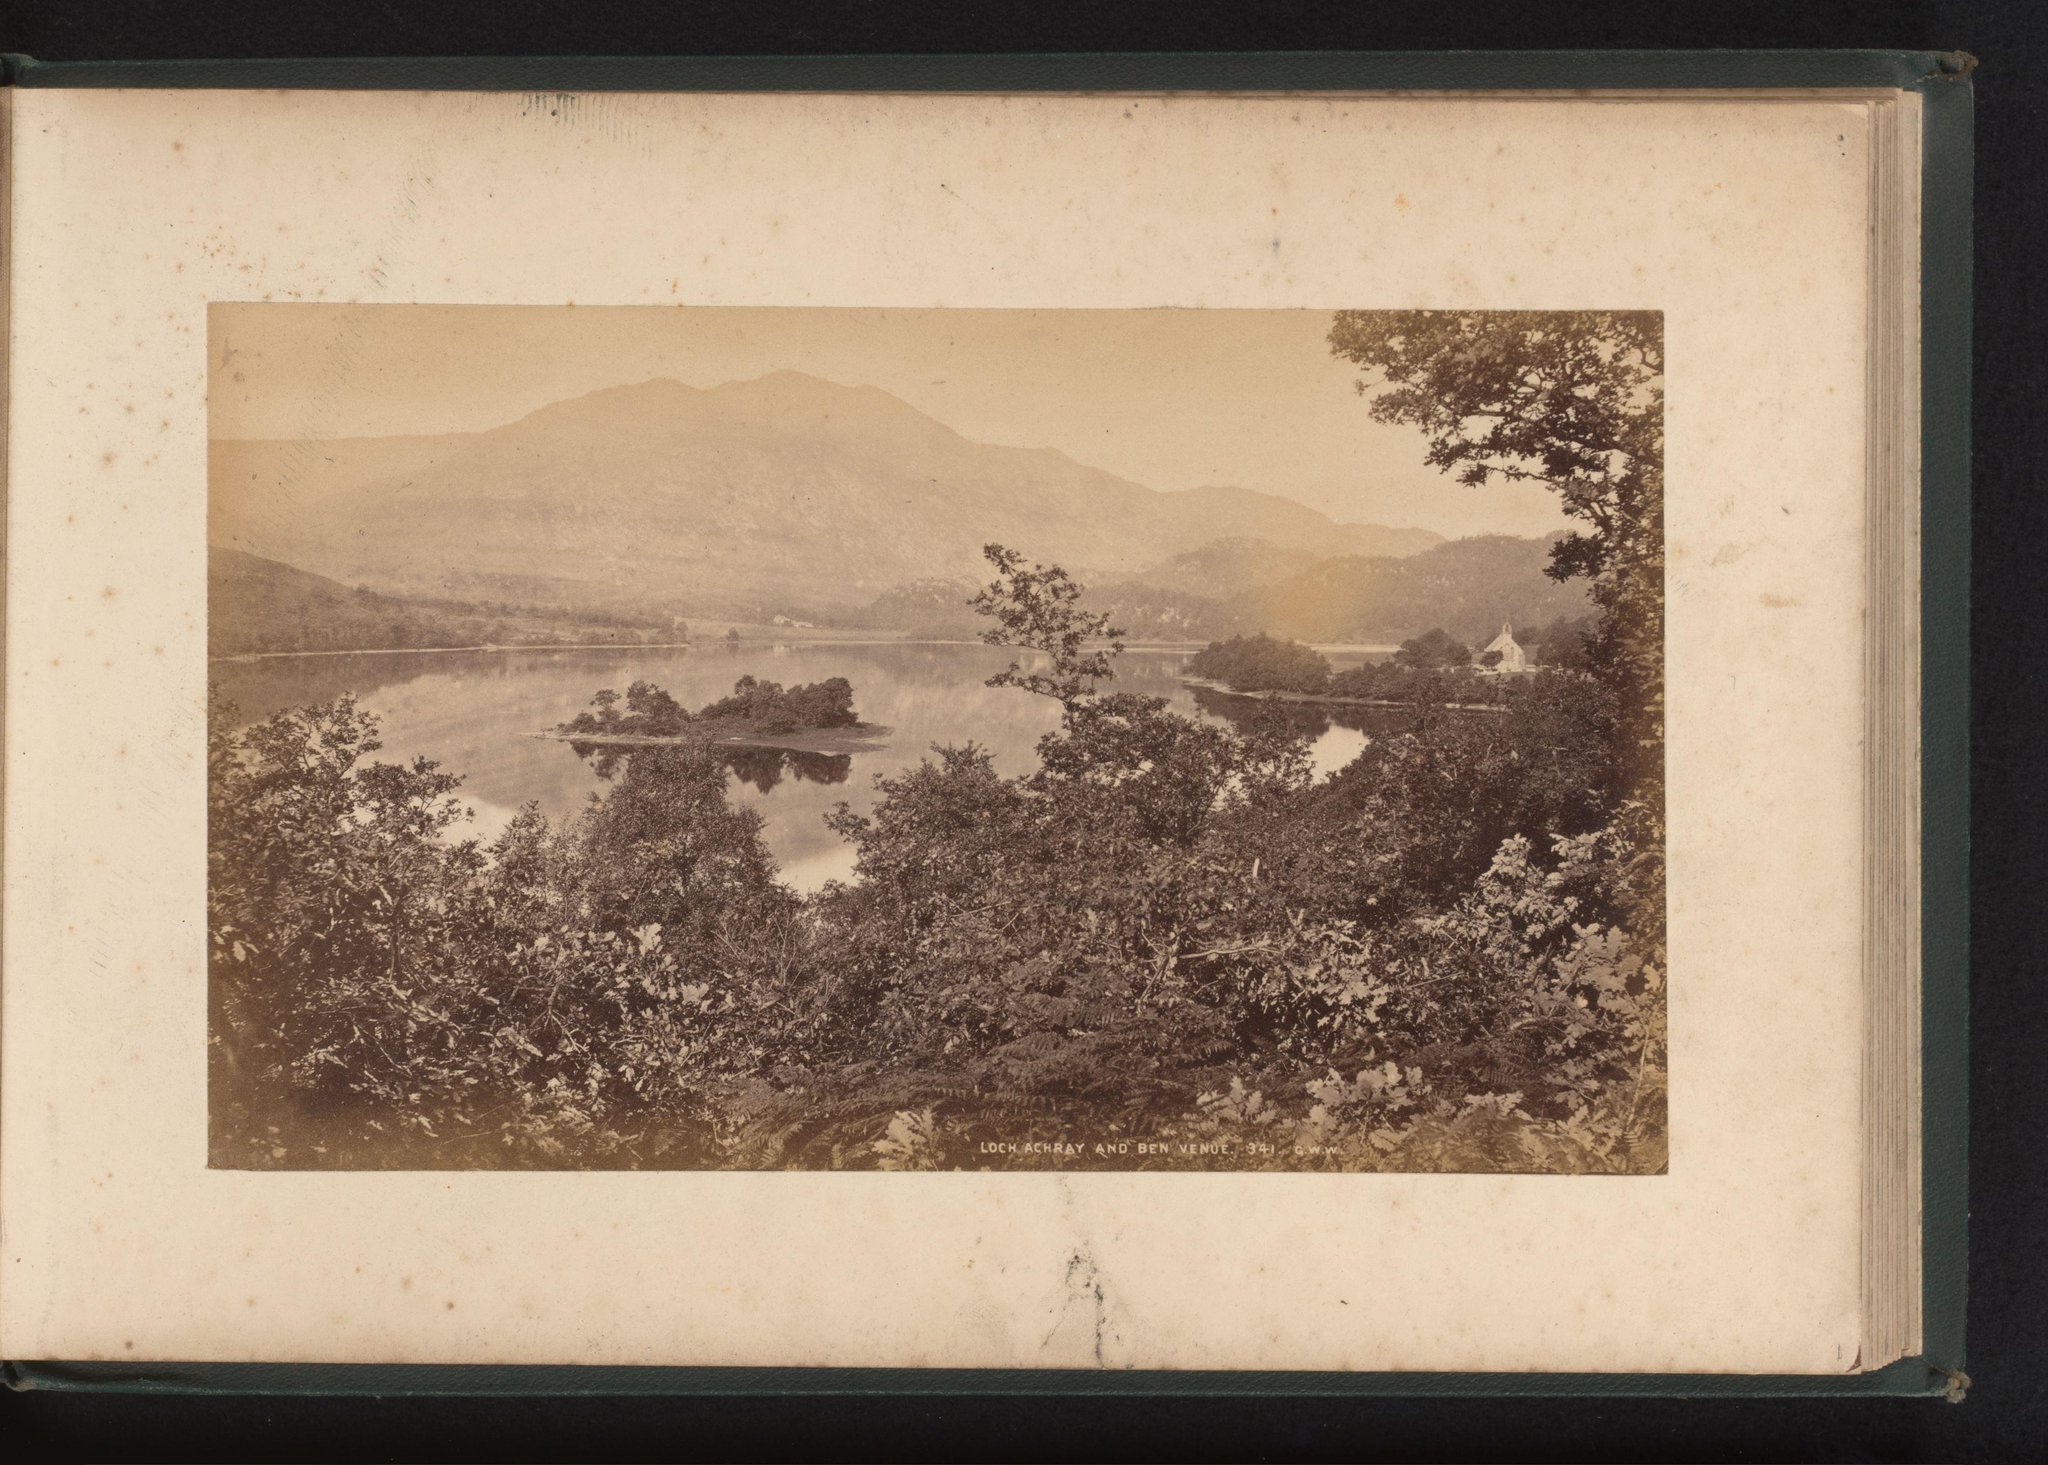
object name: photograph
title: Loch Achray and Ben Venue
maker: george washington wilson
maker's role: publisher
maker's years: 1823-1893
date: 1865-1880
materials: photographic support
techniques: albumen print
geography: scotland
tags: landscapes with waters, waterscapes, seascapes (in the temperate zone), mountains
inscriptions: number: ‘341, G.W.W.’